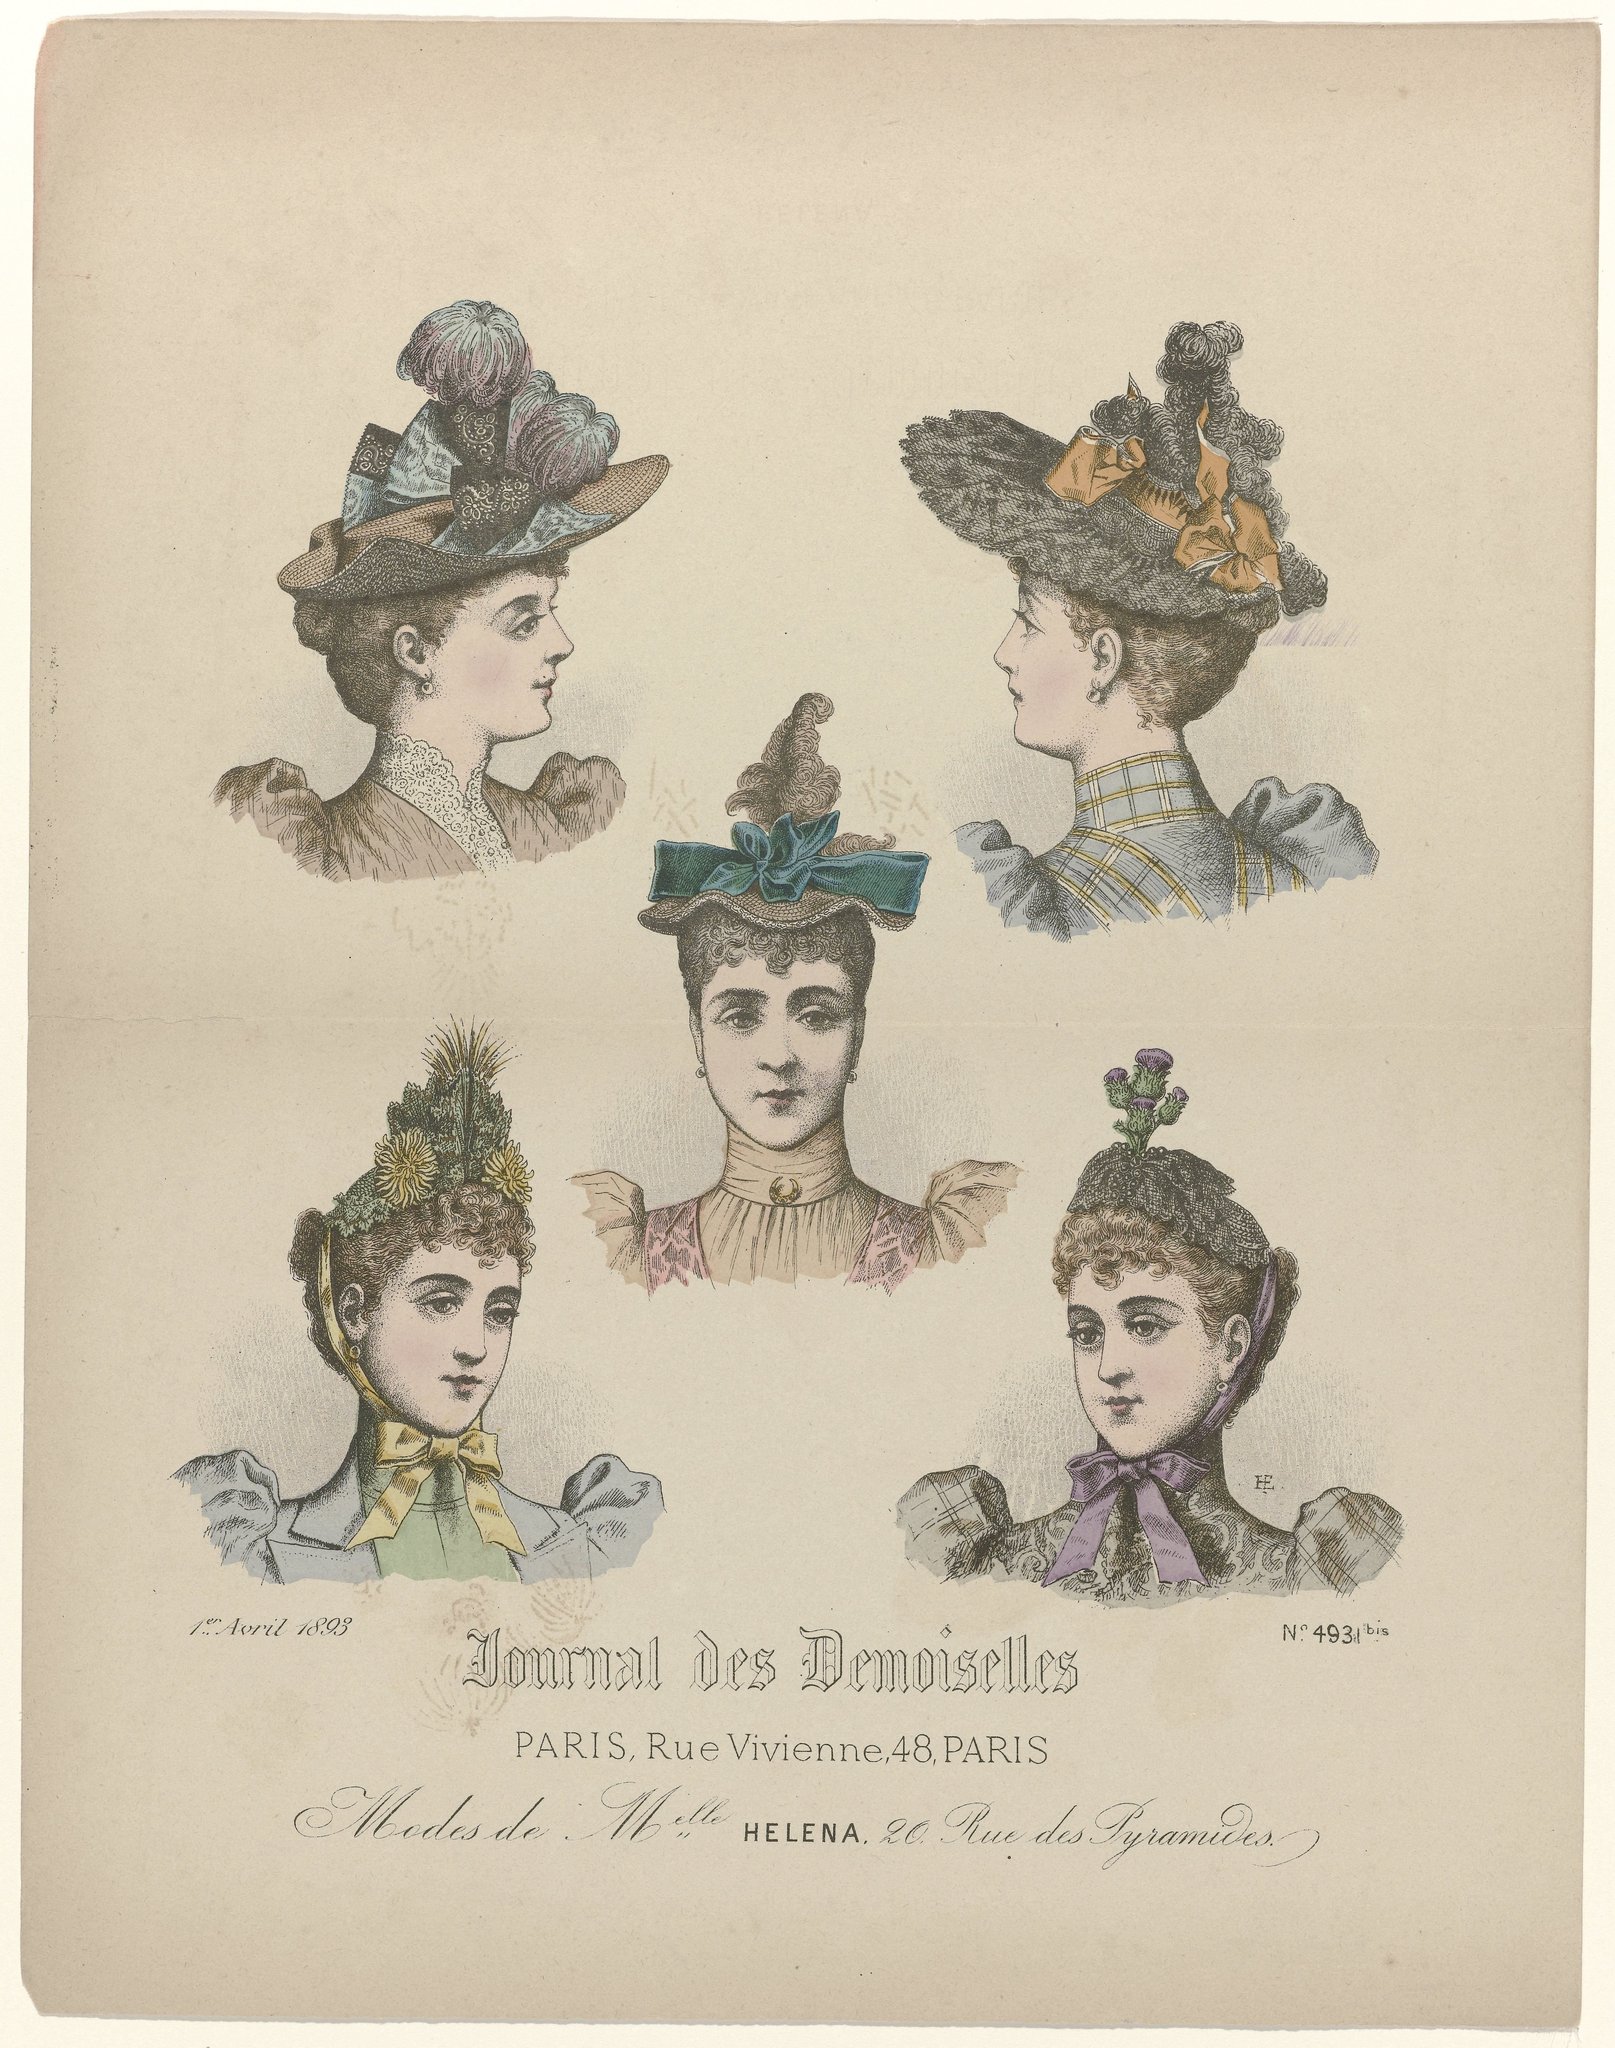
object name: fashion print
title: Journal des Demoiselles, 1 avril 1893, No. 4931 bis: Modes de Melle Helena..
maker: Anonymous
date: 1893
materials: paper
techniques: engraving, hand coloring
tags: fashion plates, head-gear: hat (+ women's clothes)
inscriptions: title: ‘Journal des Demoiselles’, caption: ‘Modes de M.elle Helena, 20, Rue des Pyramides.’, address: ‘Paris, Rue Vivienne, 48, Paris’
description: Vijf vrouwenhoofden met verschillende hoeden. Volgens het onderschrift: 'modes' van Helena. Prent uit het modetijdschrift Journal des Demoiselles (1833 -1922).